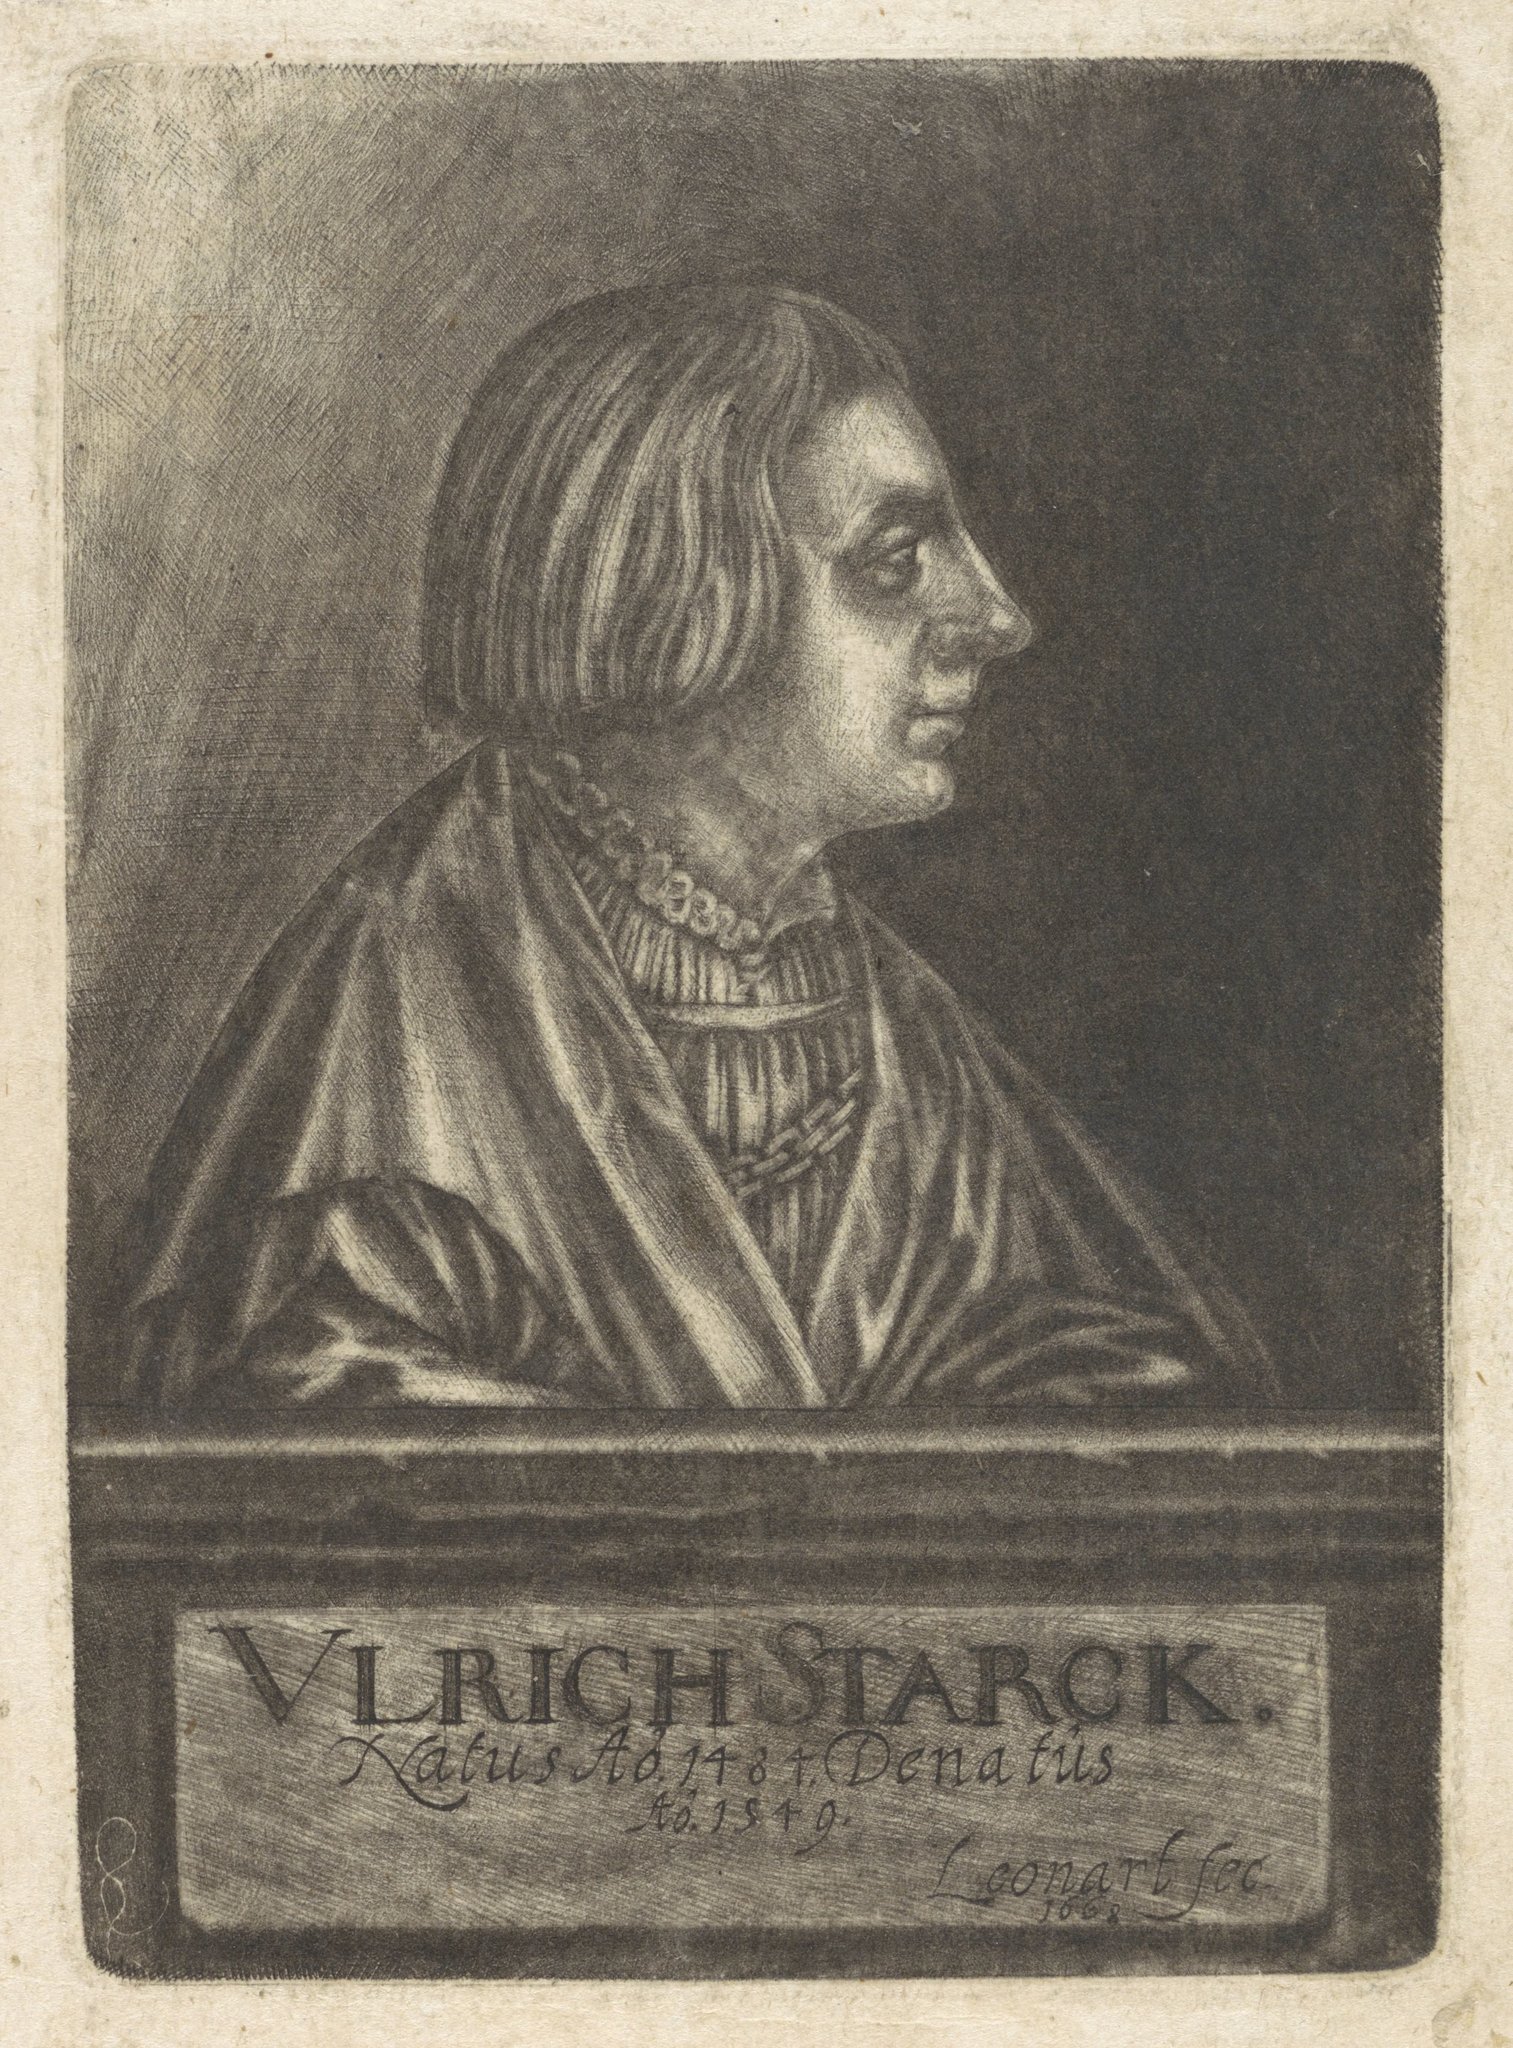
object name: print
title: Portret van Ulrich Starck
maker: johann friedrich leonard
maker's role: print maker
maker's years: 1633-1680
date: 1668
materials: paper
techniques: engraving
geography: nuremberg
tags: ulrich starck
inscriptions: collector's mark: Lugt 2228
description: De patriciër uit Neurenberg Ulrich Starck, in profiel.